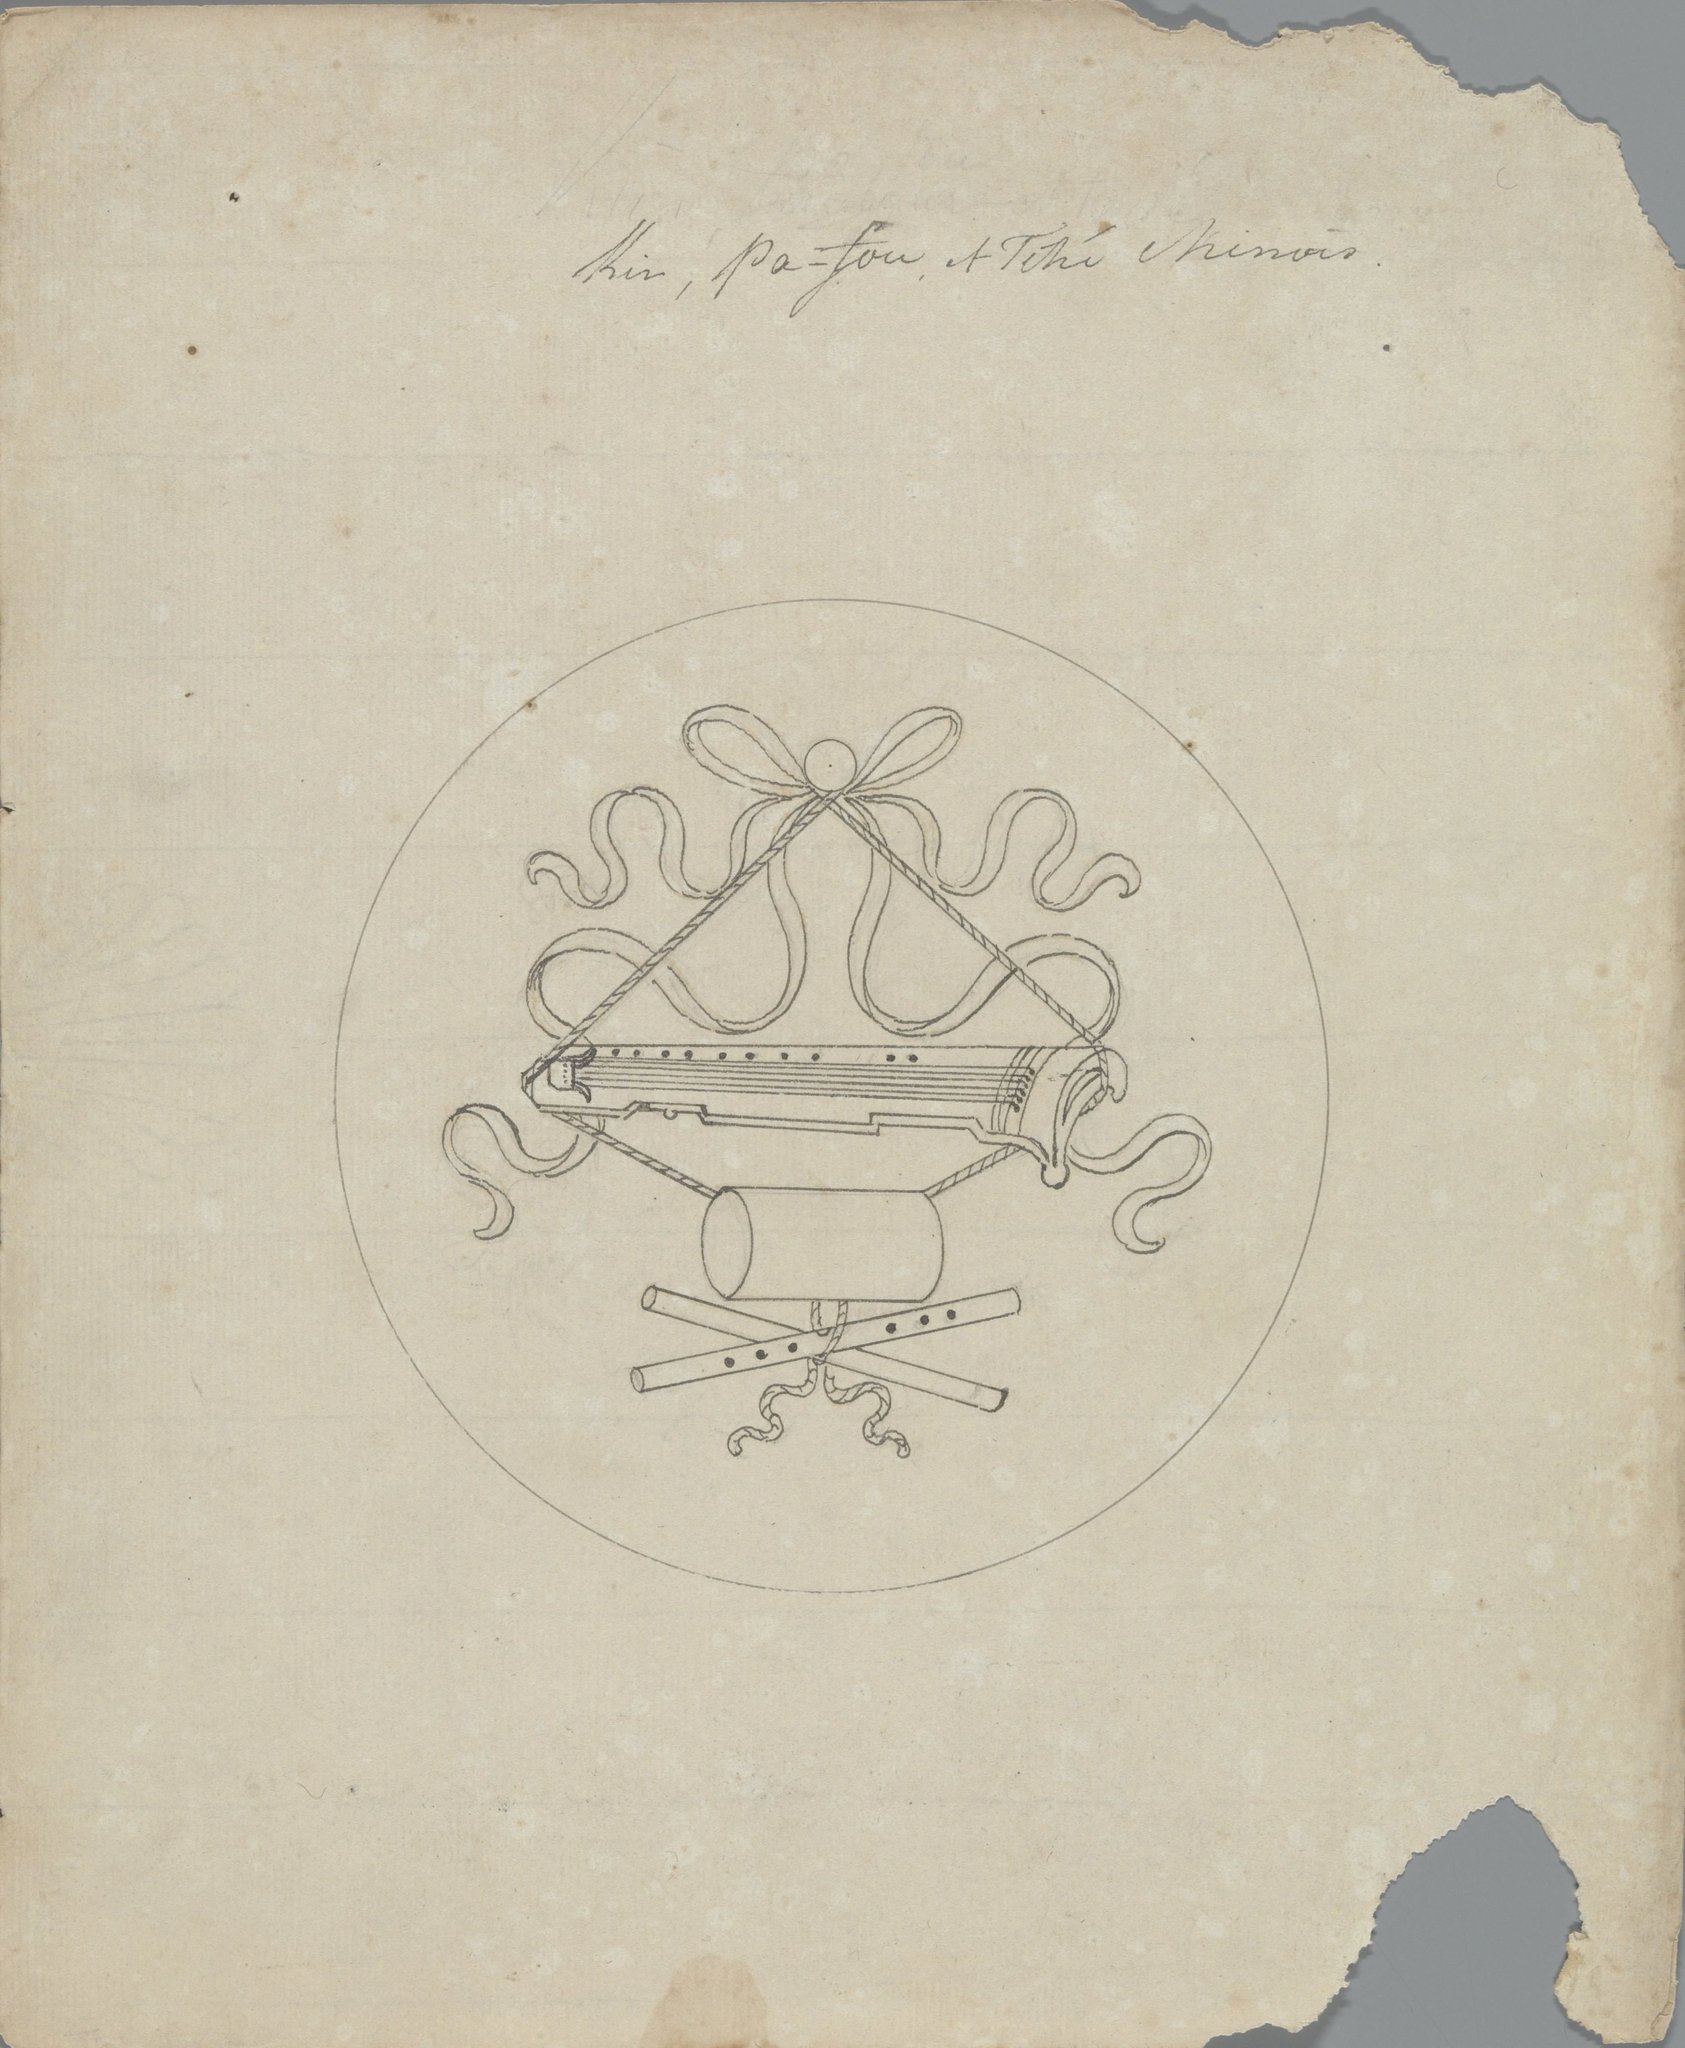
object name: design drawing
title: Ontwerp voor marqueterie van aan linten opgehangen muziekinstrument(en) in rond medaillon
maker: pierre félix van doren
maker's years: 1797-1856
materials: graphite, ink, paper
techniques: pen in black ink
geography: brussels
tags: musical instruments; group of musical instruments, trophy, i.e.: decorative arrangement of symbolic or typical objects ~ ornament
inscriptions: watermark, inscription: ‘Kin, Pa-fou et Tchi chinois’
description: Een van 103 ontwerpen voor marqueterie van aan linten opgehangen muziekinstrumenten in ronde medaillons, bestemd voor de set stoelen gemaakt door Van Doren voor de grote zaal van het Paleis van de Prins van Oranje in Brussel in 1828.